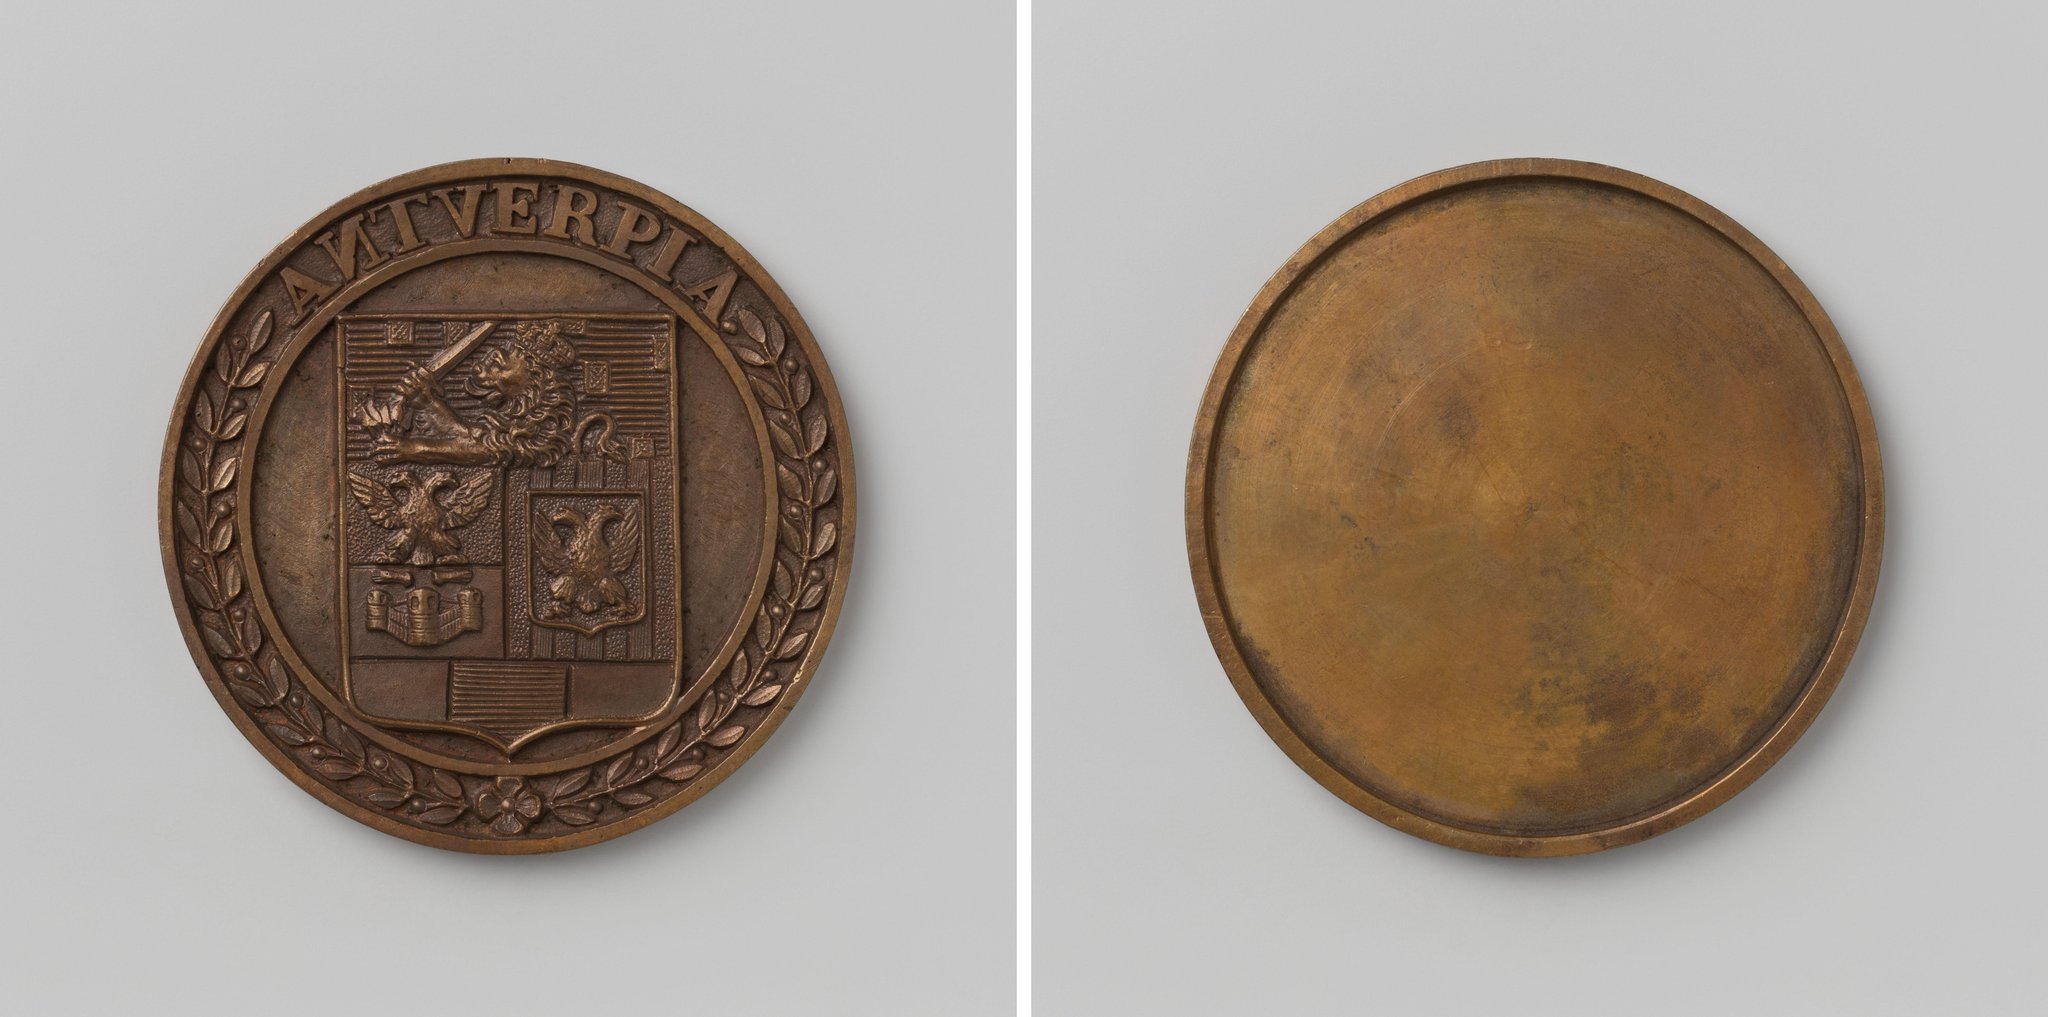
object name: medal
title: Antwerpen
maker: Anonymous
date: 1815-1830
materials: bronze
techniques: striking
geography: netherlands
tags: antwerp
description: Eenzijdige bronzen penning. Voorzijde: wapenschild binnen bladerkrans en omschrift. Keerzijde: blanco